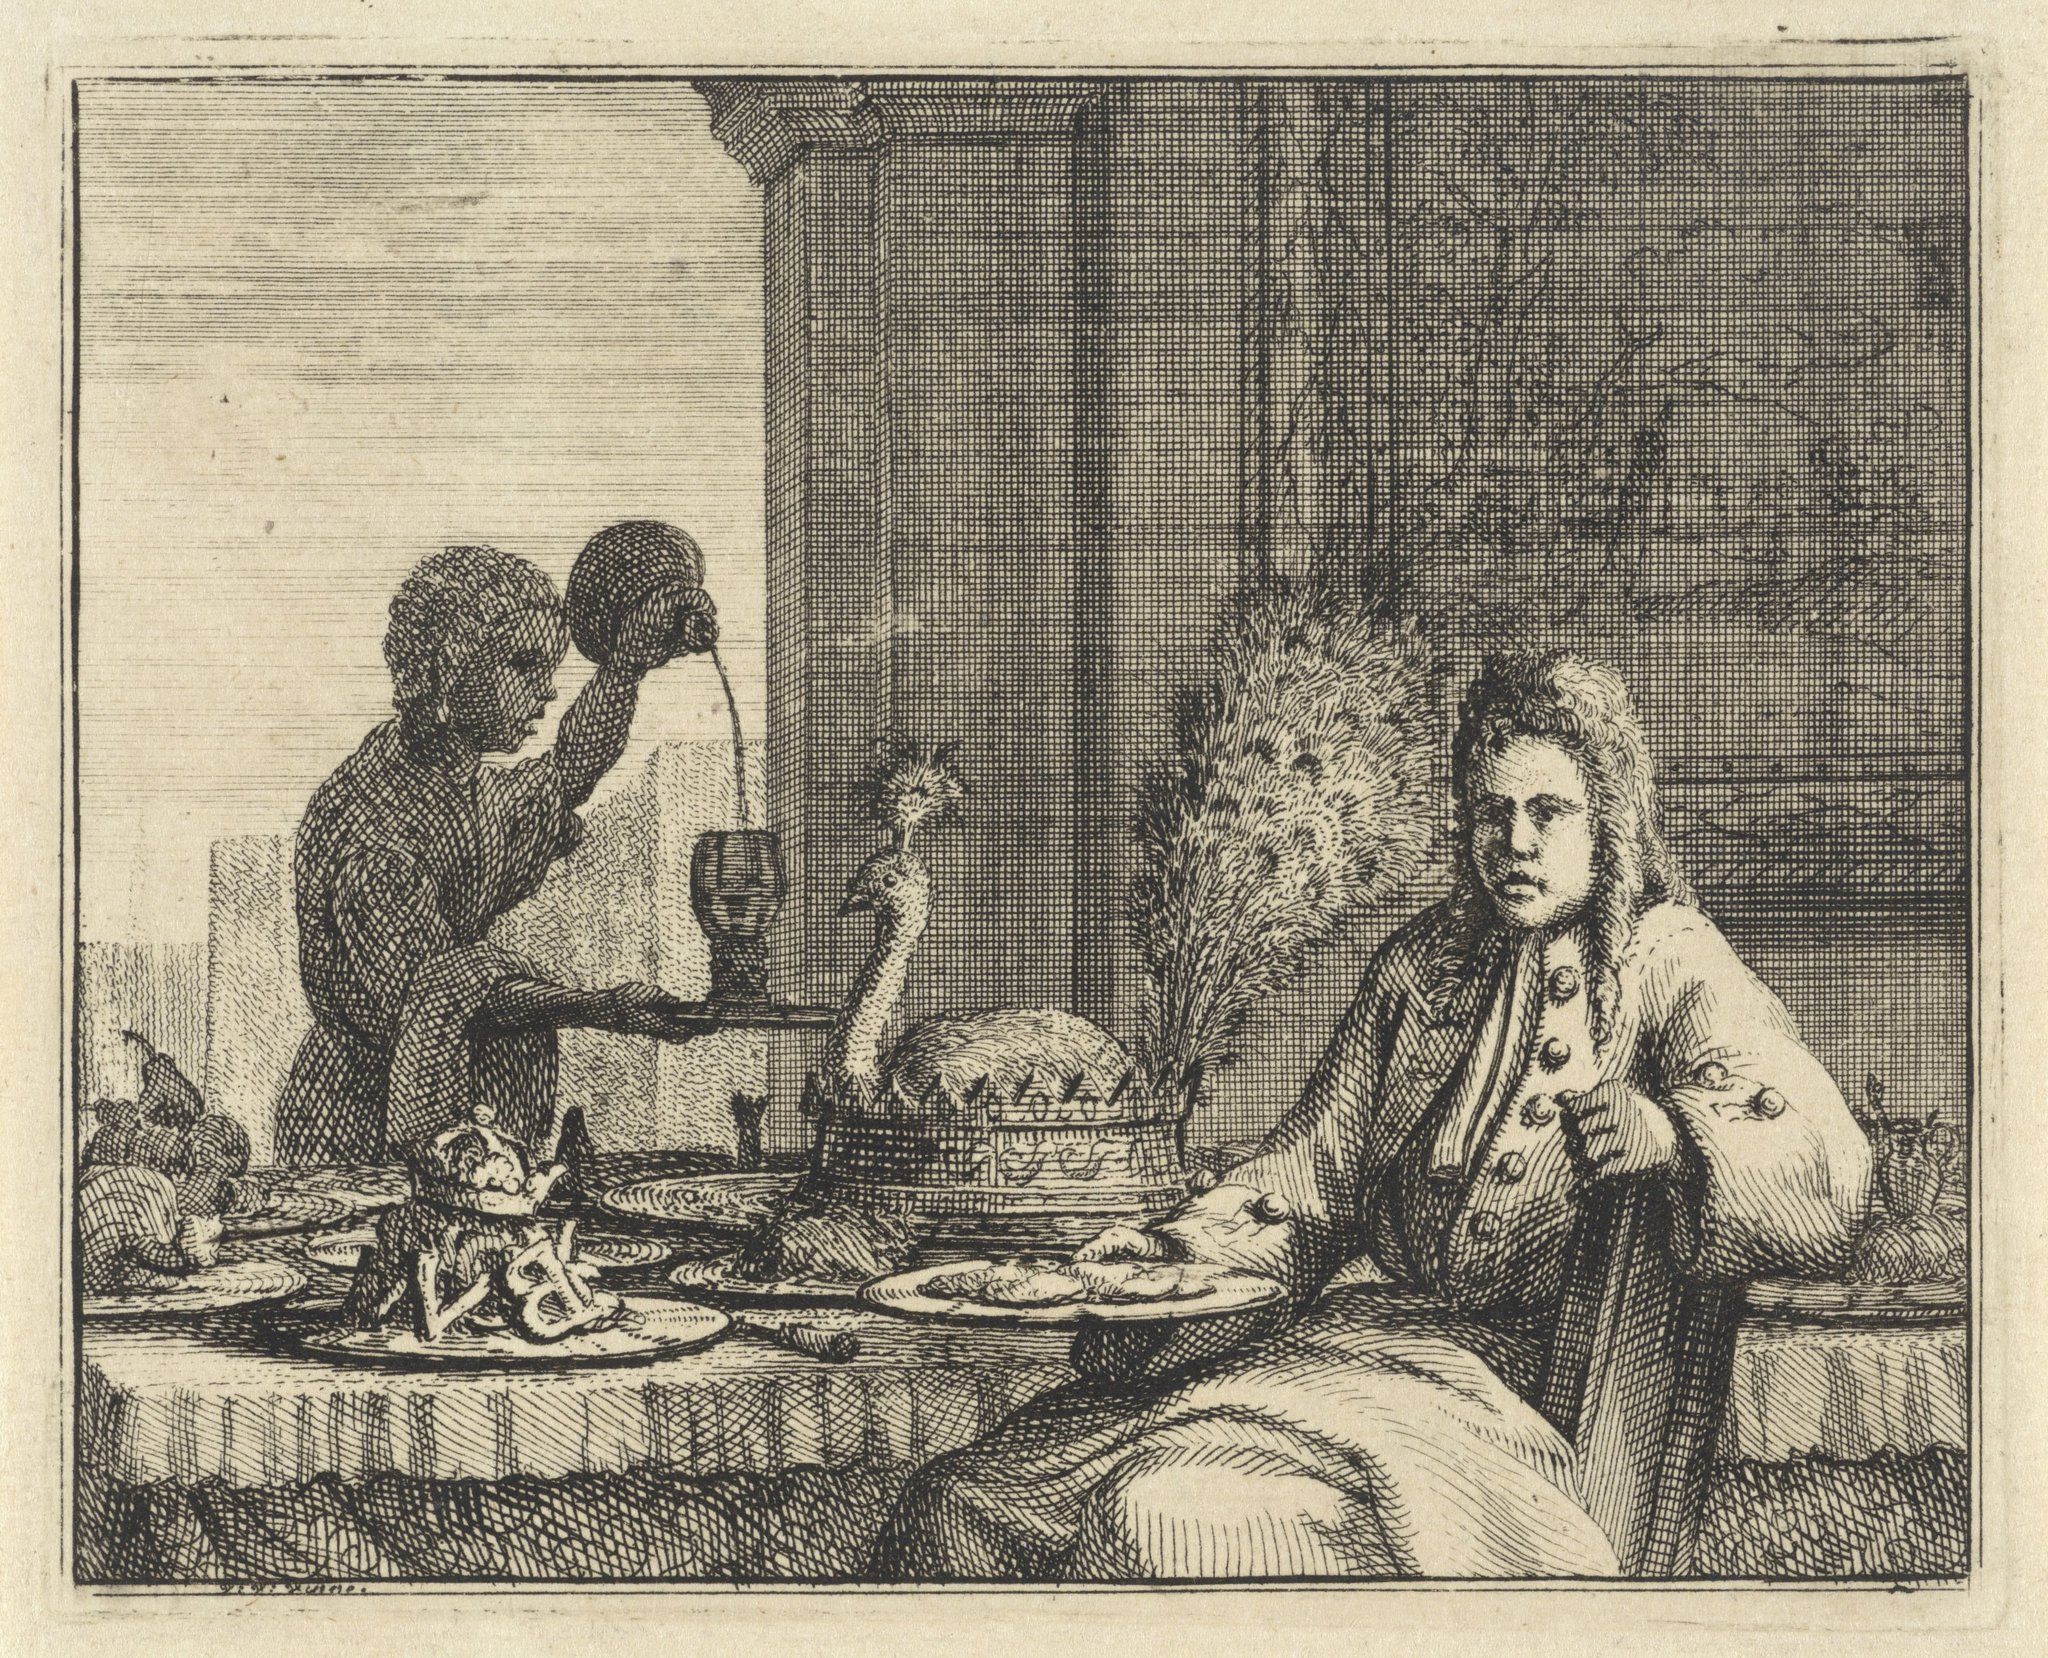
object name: print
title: Man bij een gedekte tafel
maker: vincent laurensz. van der vinne (ii)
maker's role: draughtsman, print maker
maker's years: 1686-1742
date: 1714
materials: paper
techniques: etching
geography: haarlem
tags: celebration meal, feast, banquet, wine-steward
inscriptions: collector's mark: Lugt 2228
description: Een man zit op een stoel bij een rijk gedekte tafel, waarop een pastei met een pauw. Achter de tafel een dienaar die een glas wijn inschenkt. Zinnebeeld op de aardse schijnspijzen, tegenover die van de hemel.